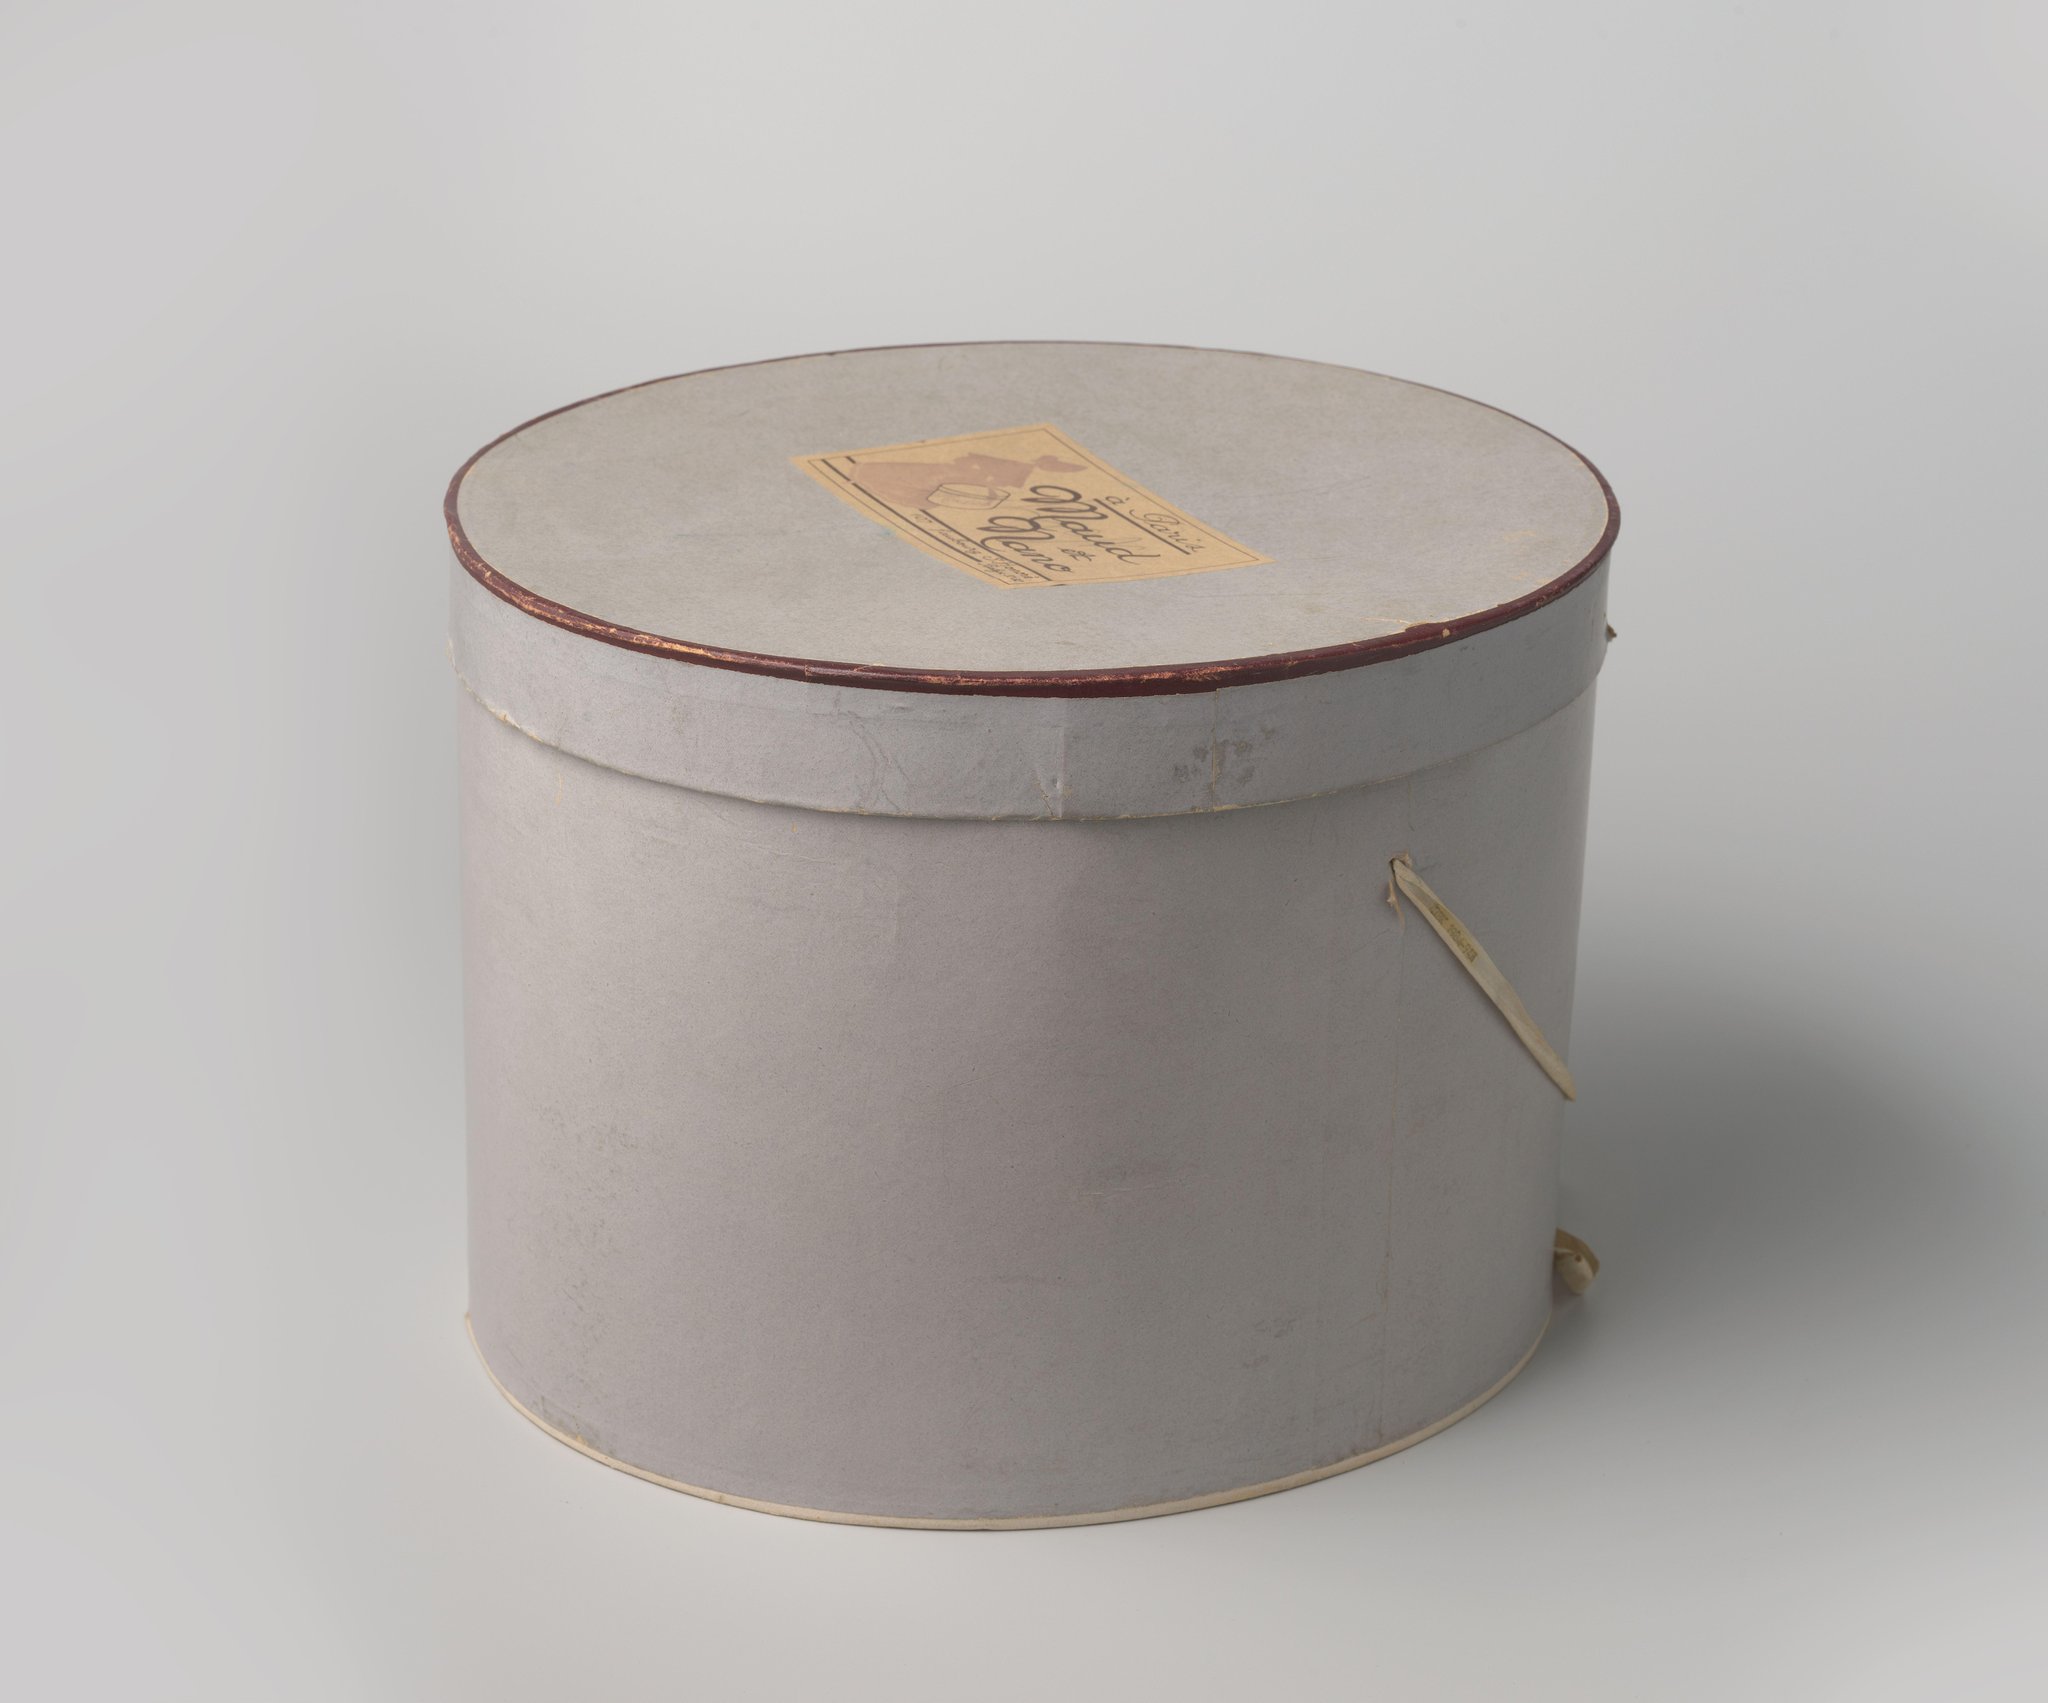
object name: womenswear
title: Ovale hoedendoos van karton, beplakt met lichtgrijs of lichtblauw papier dat op de deksel is afgezet met een bruine bies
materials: cardboard, linen, paper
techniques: pasting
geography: paris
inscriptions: company name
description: Volgens de schenkster gekocht tijdens een bezoek aan de Wereldtentoonstelling in Parijs in 1937. Echter, Maud & Nano begonnen pas in 1942 met hun modehuis.